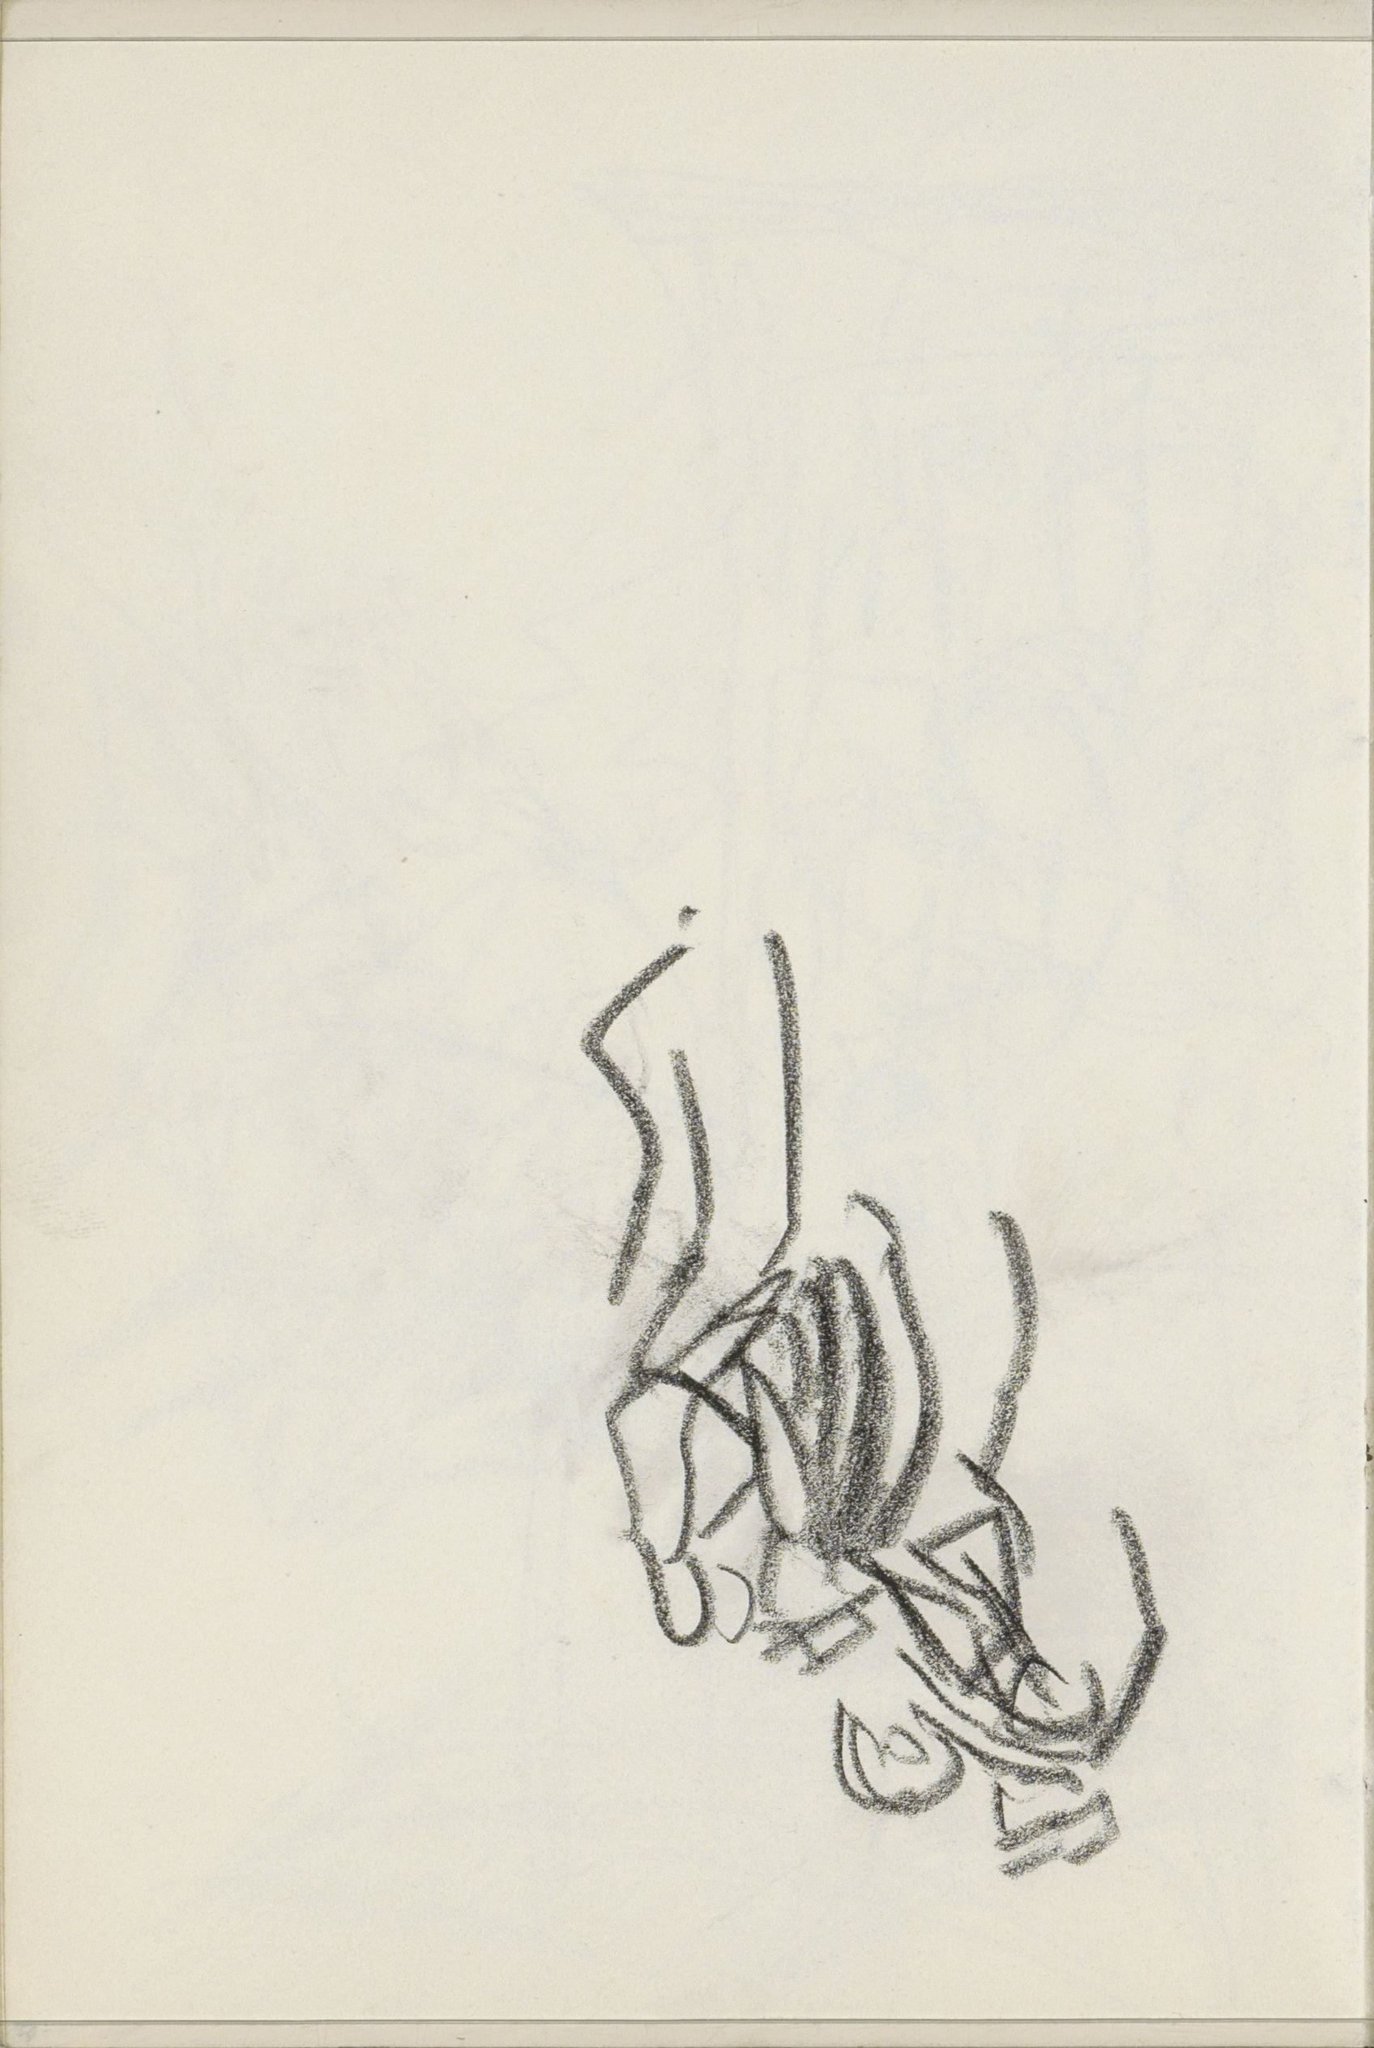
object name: sketchbook leaf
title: Twee dansparen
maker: isaac israels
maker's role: draughtsman, painter, print maker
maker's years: 1865-1934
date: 1875-1934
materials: chalk, paper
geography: paris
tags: one pair dancing; man and woman dancing as a couple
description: Blad 28 verso uit schetsboek L met 42 bladen.